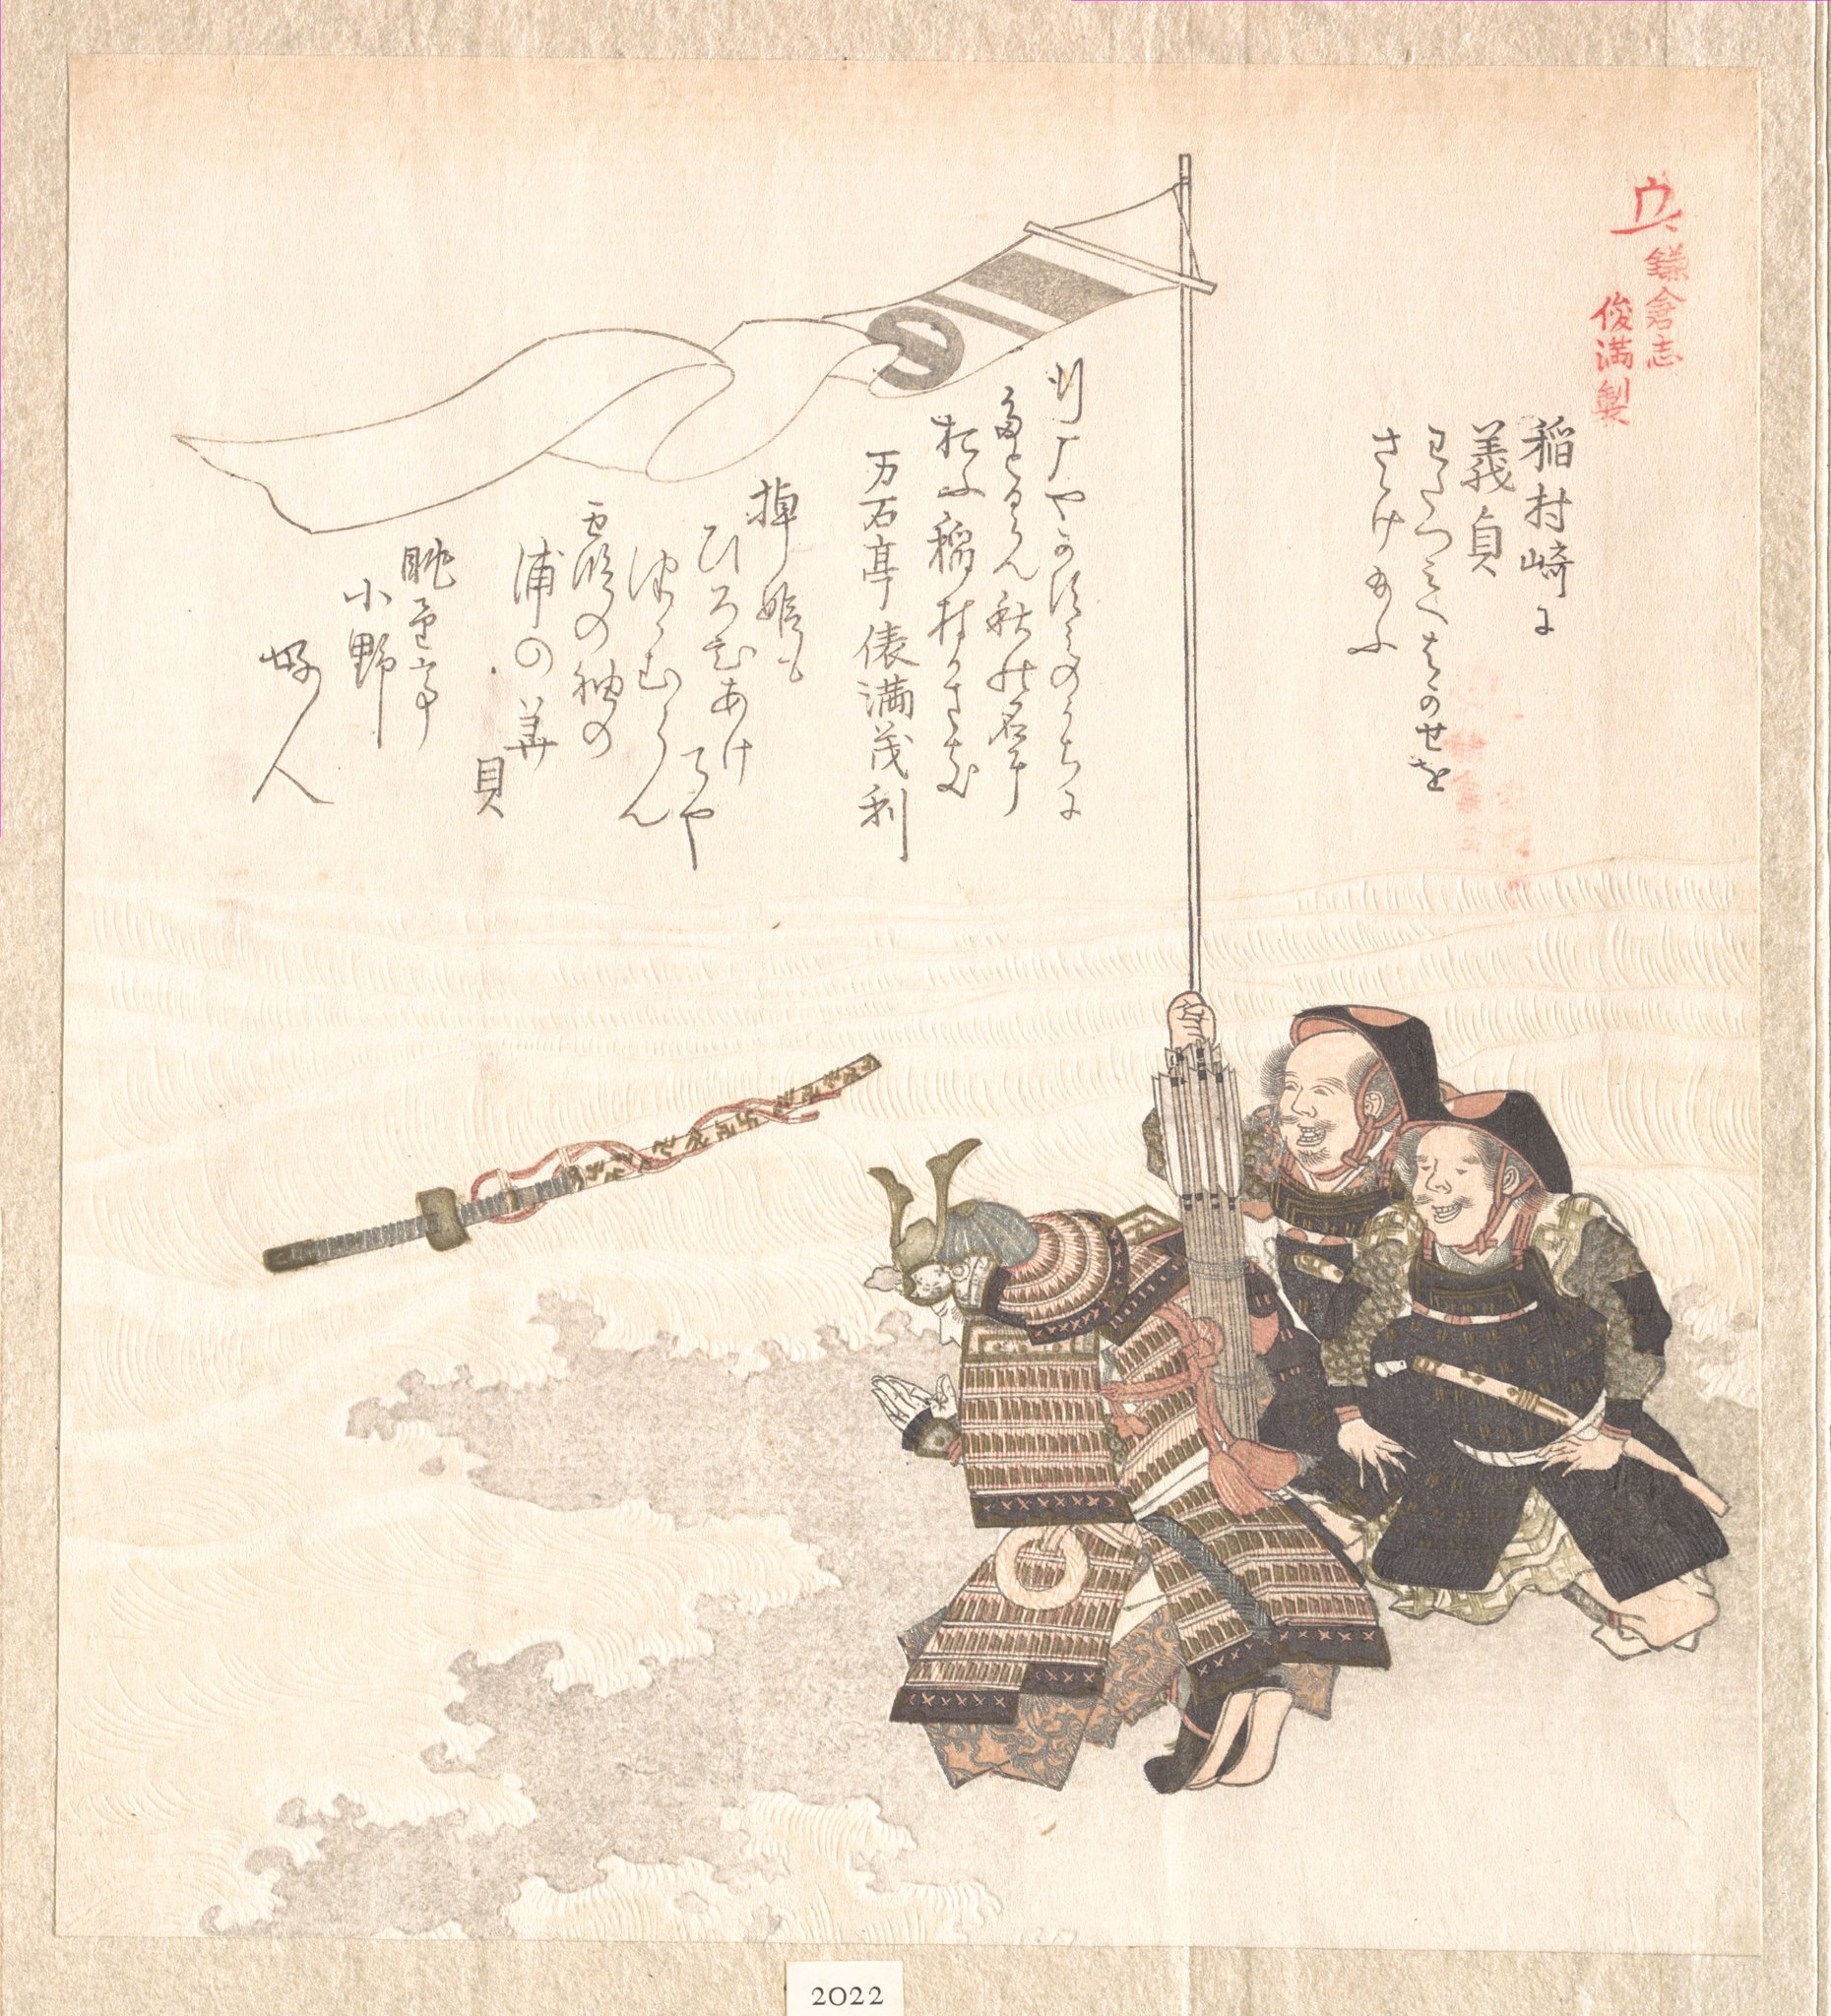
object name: print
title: History of Kamakura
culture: japanese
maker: totoya hokkei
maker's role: artist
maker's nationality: japanese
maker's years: 1780-1850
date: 1801-1900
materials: ink, paper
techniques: surimono, woodblock print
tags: swords,men